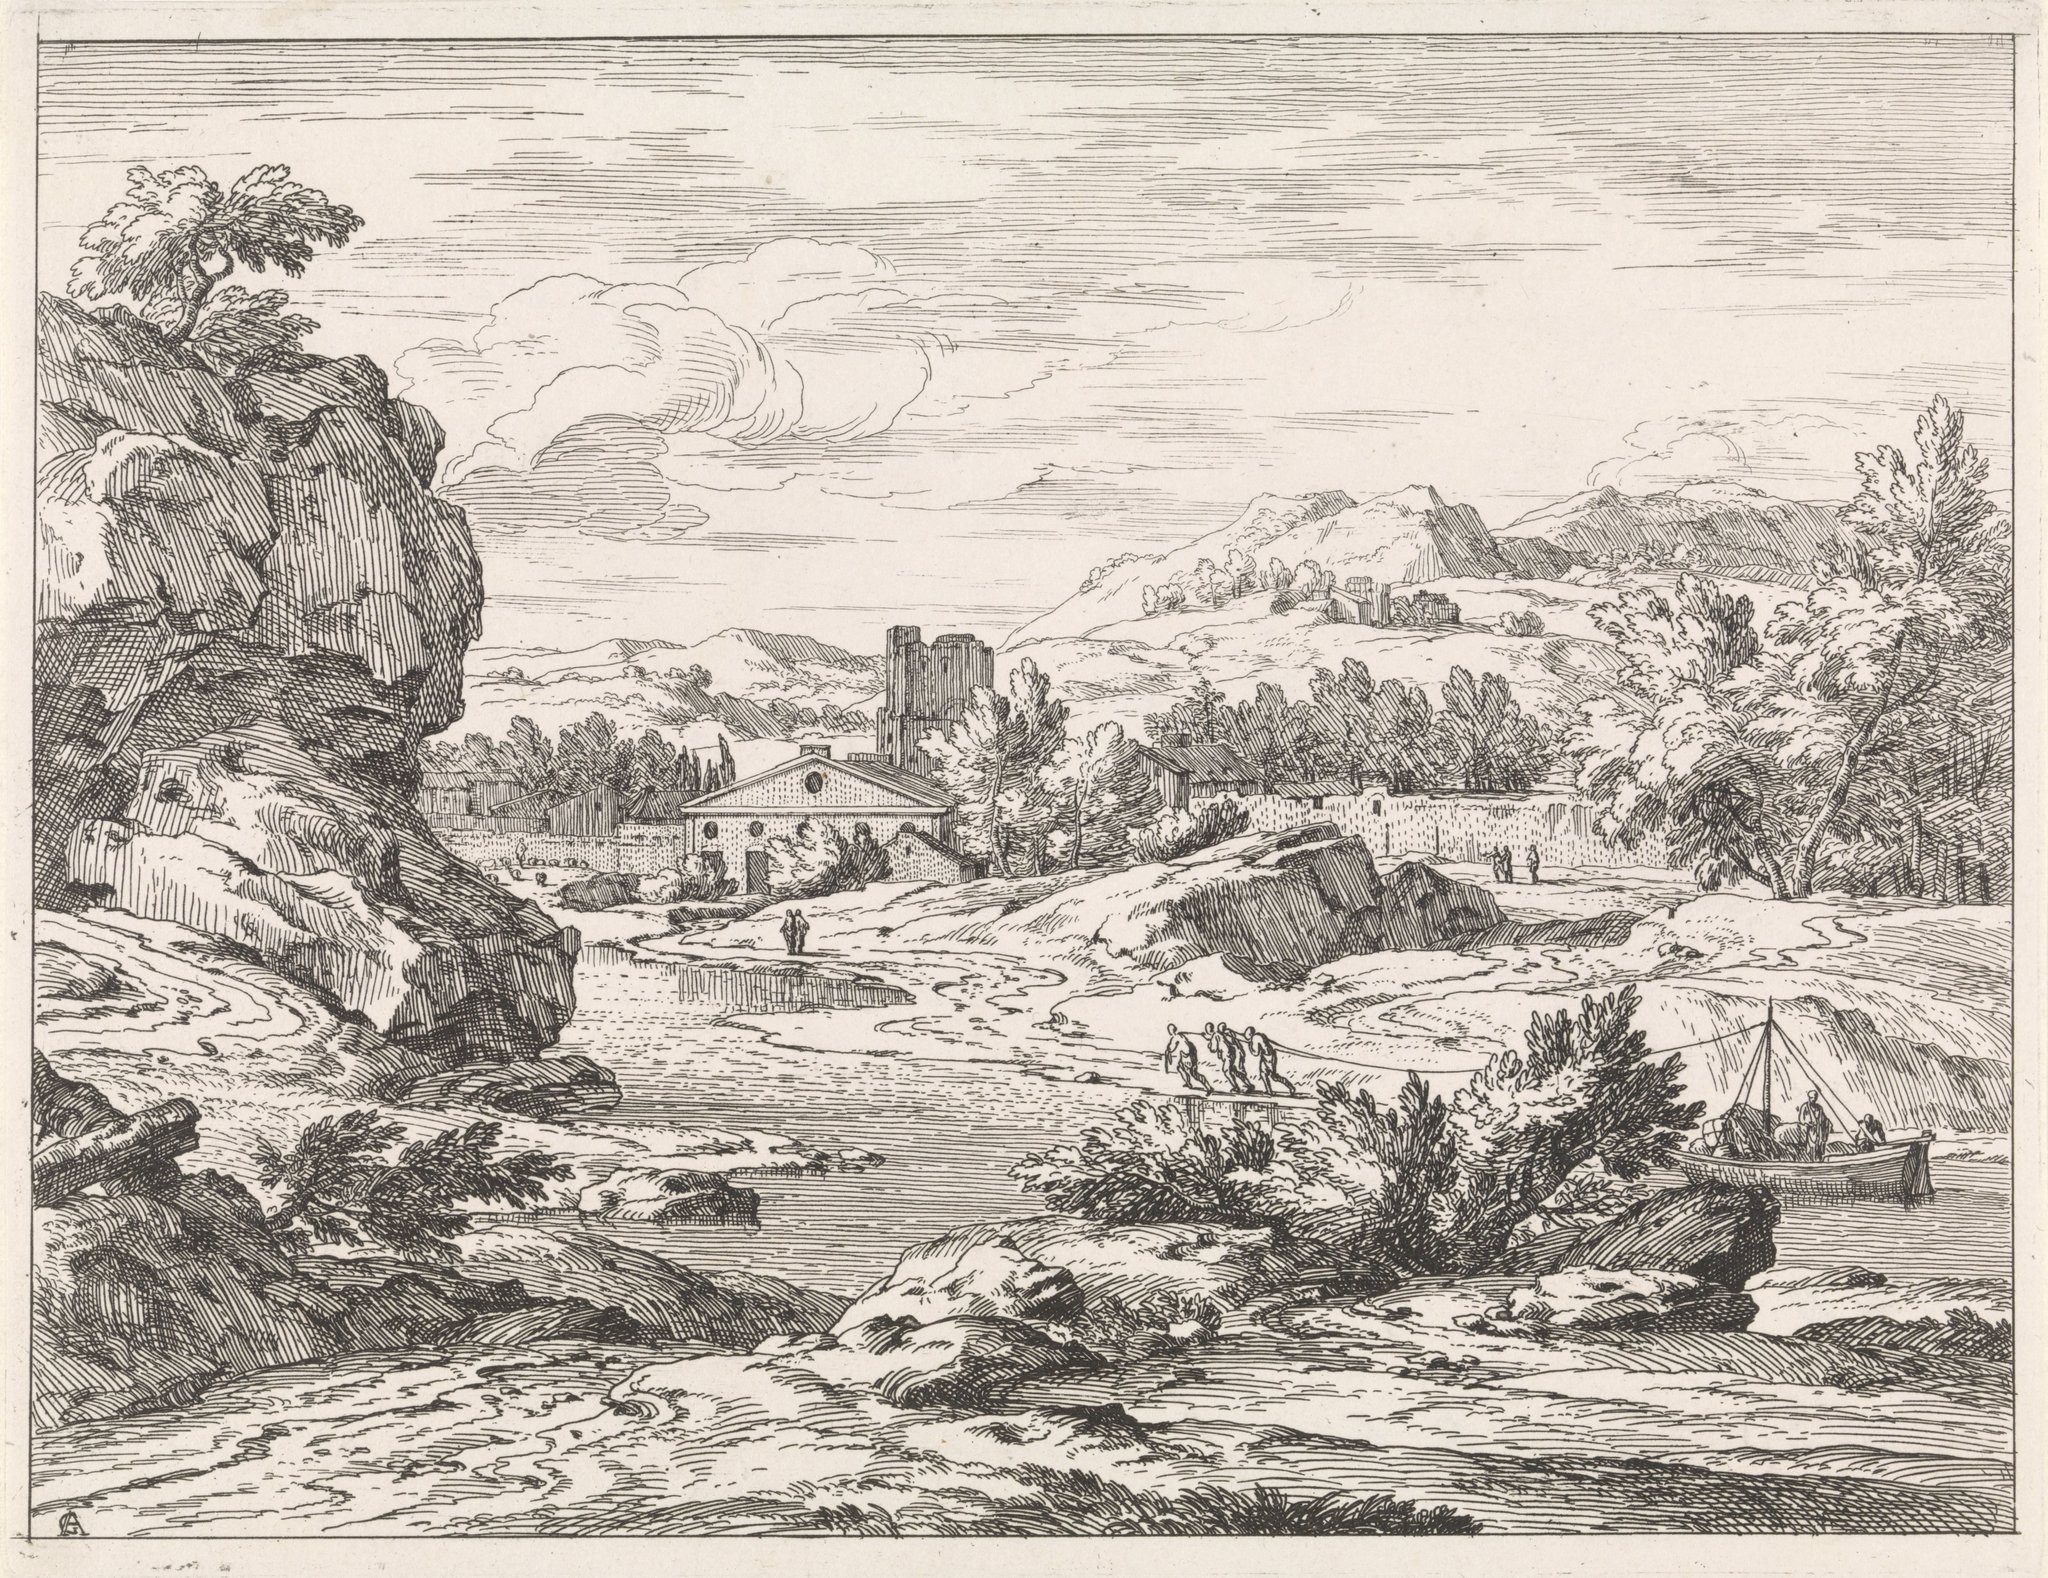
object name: print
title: Rivierlandschappen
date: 1650-1690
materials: paper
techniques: etching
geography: paris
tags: (high) hill, river (+ landscape with figures, staffage), tug, pusher tug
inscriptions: collector's mark: Lugt 240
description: Een heuvelachtig landschap met een rivier. Rechts op de voorgrond een trekschuit. De prent maakt deel uit van een serie van rivierlandschappen.